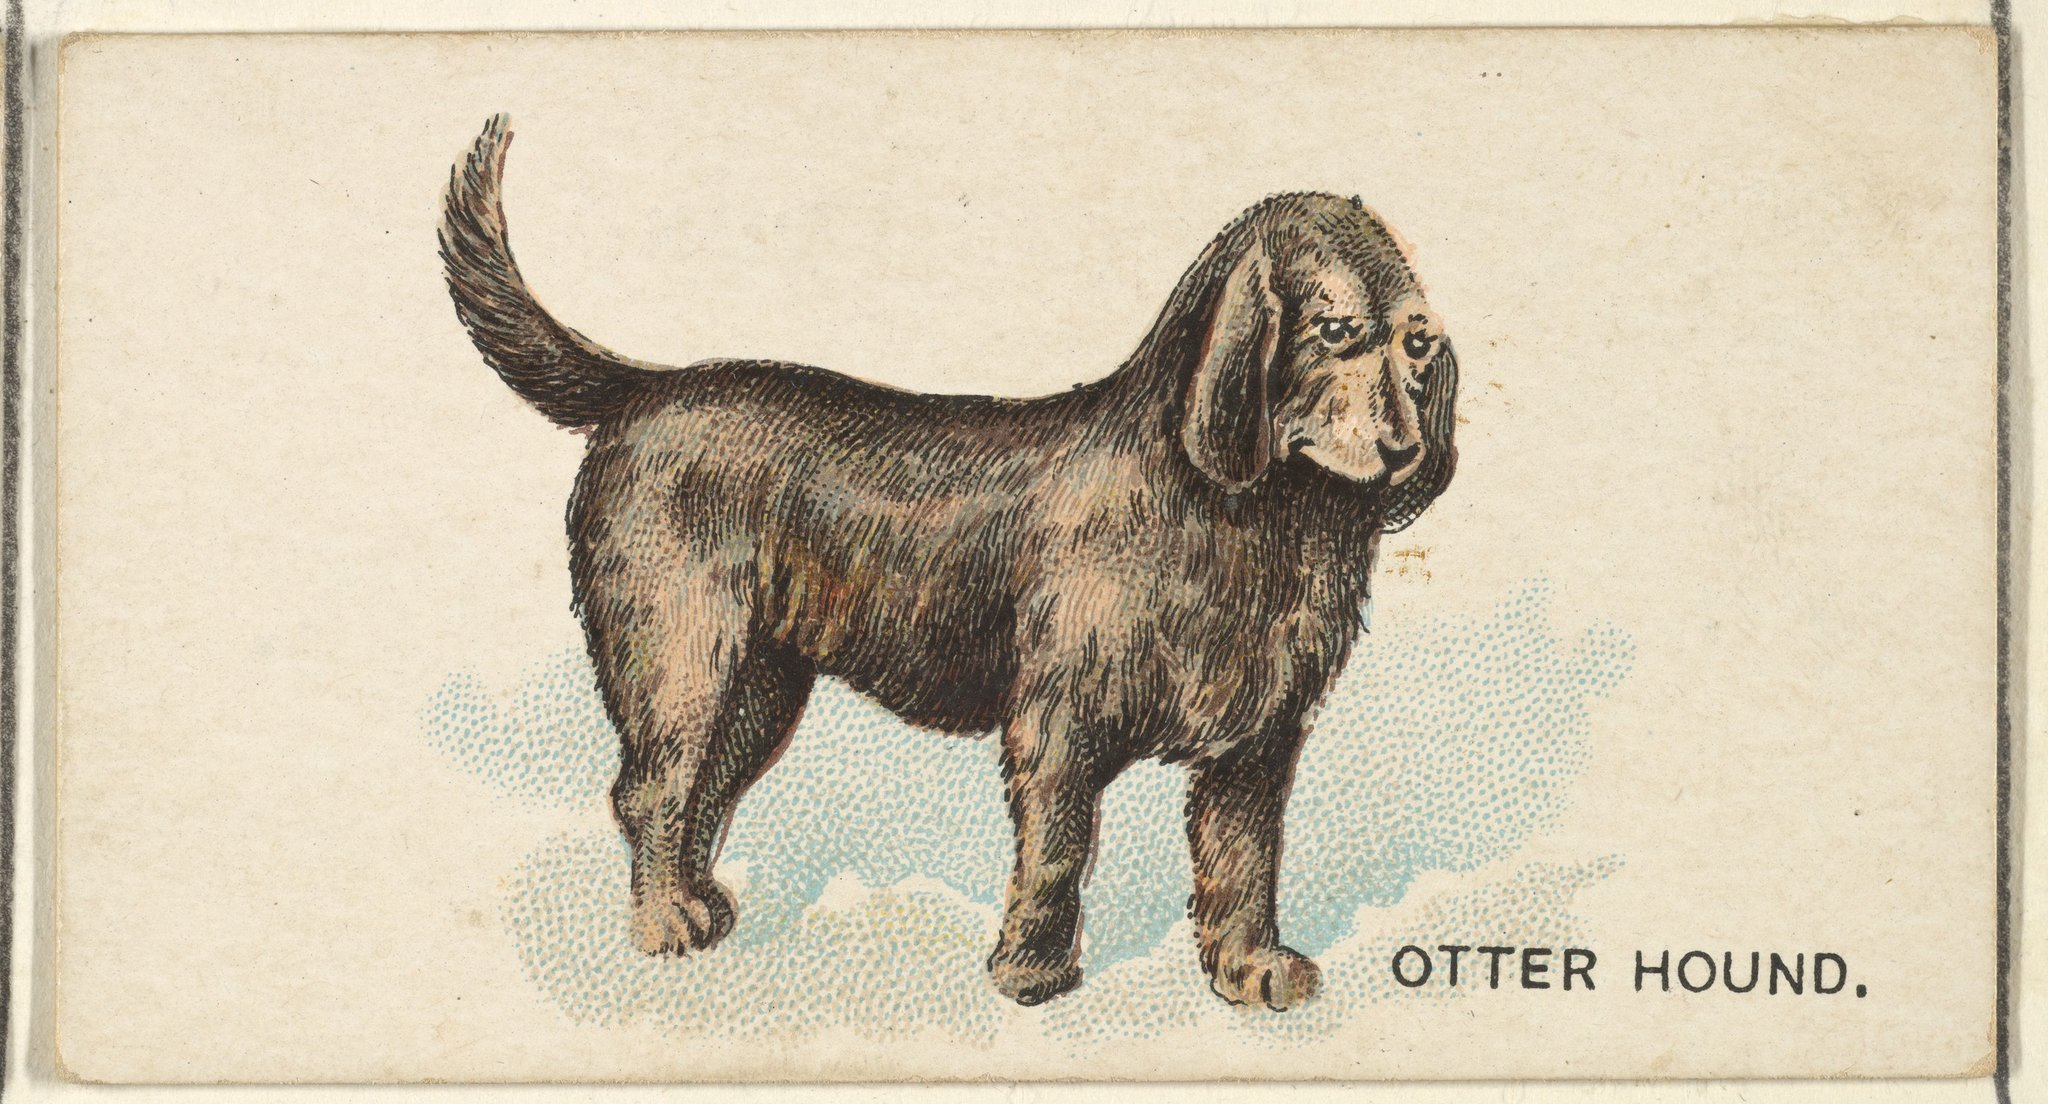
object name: print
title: Otter Hound, from the Dogs of the World series for Old Judge Cigarettes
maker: goodwin & company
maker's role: publisher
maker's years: 1850-1950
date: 1890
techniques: color lithograph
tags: dogs